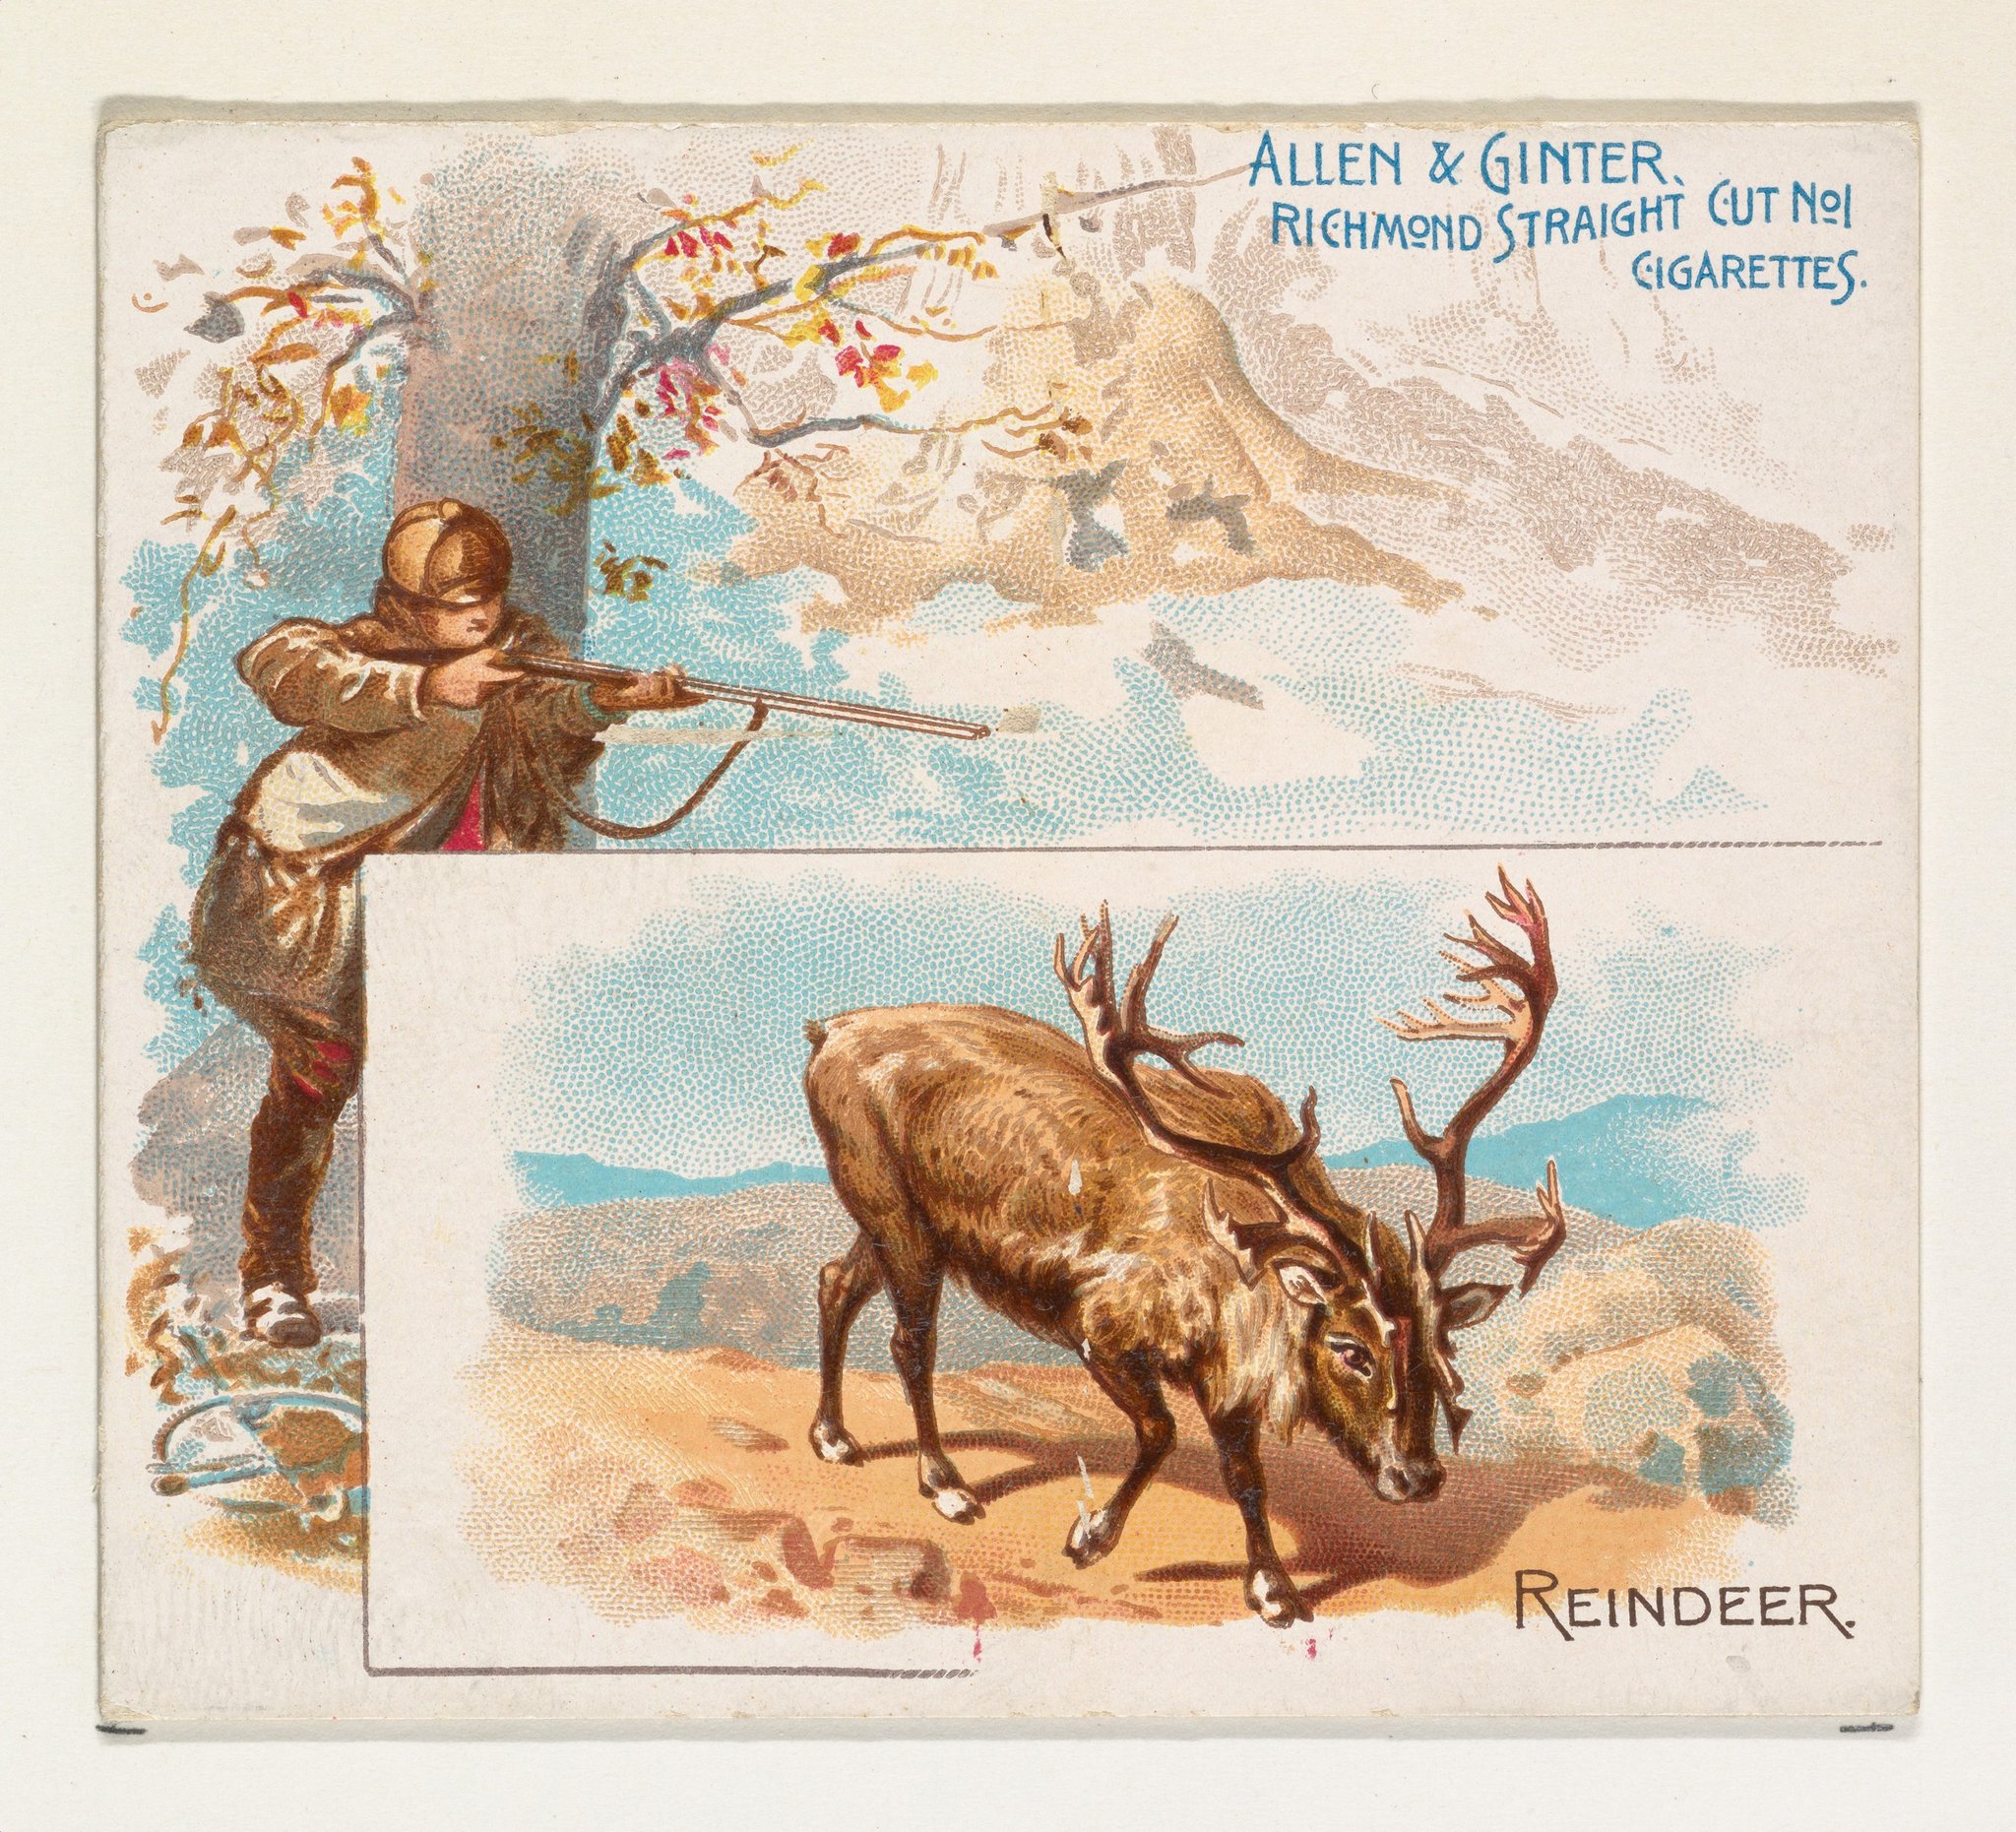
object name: print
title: Reindeer, from Quadrupeds series (N41) for Allen & Ginter Cigarettes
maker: allen & ginter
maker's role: publisher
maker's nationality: american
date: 1890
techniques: color lithograph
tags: animals